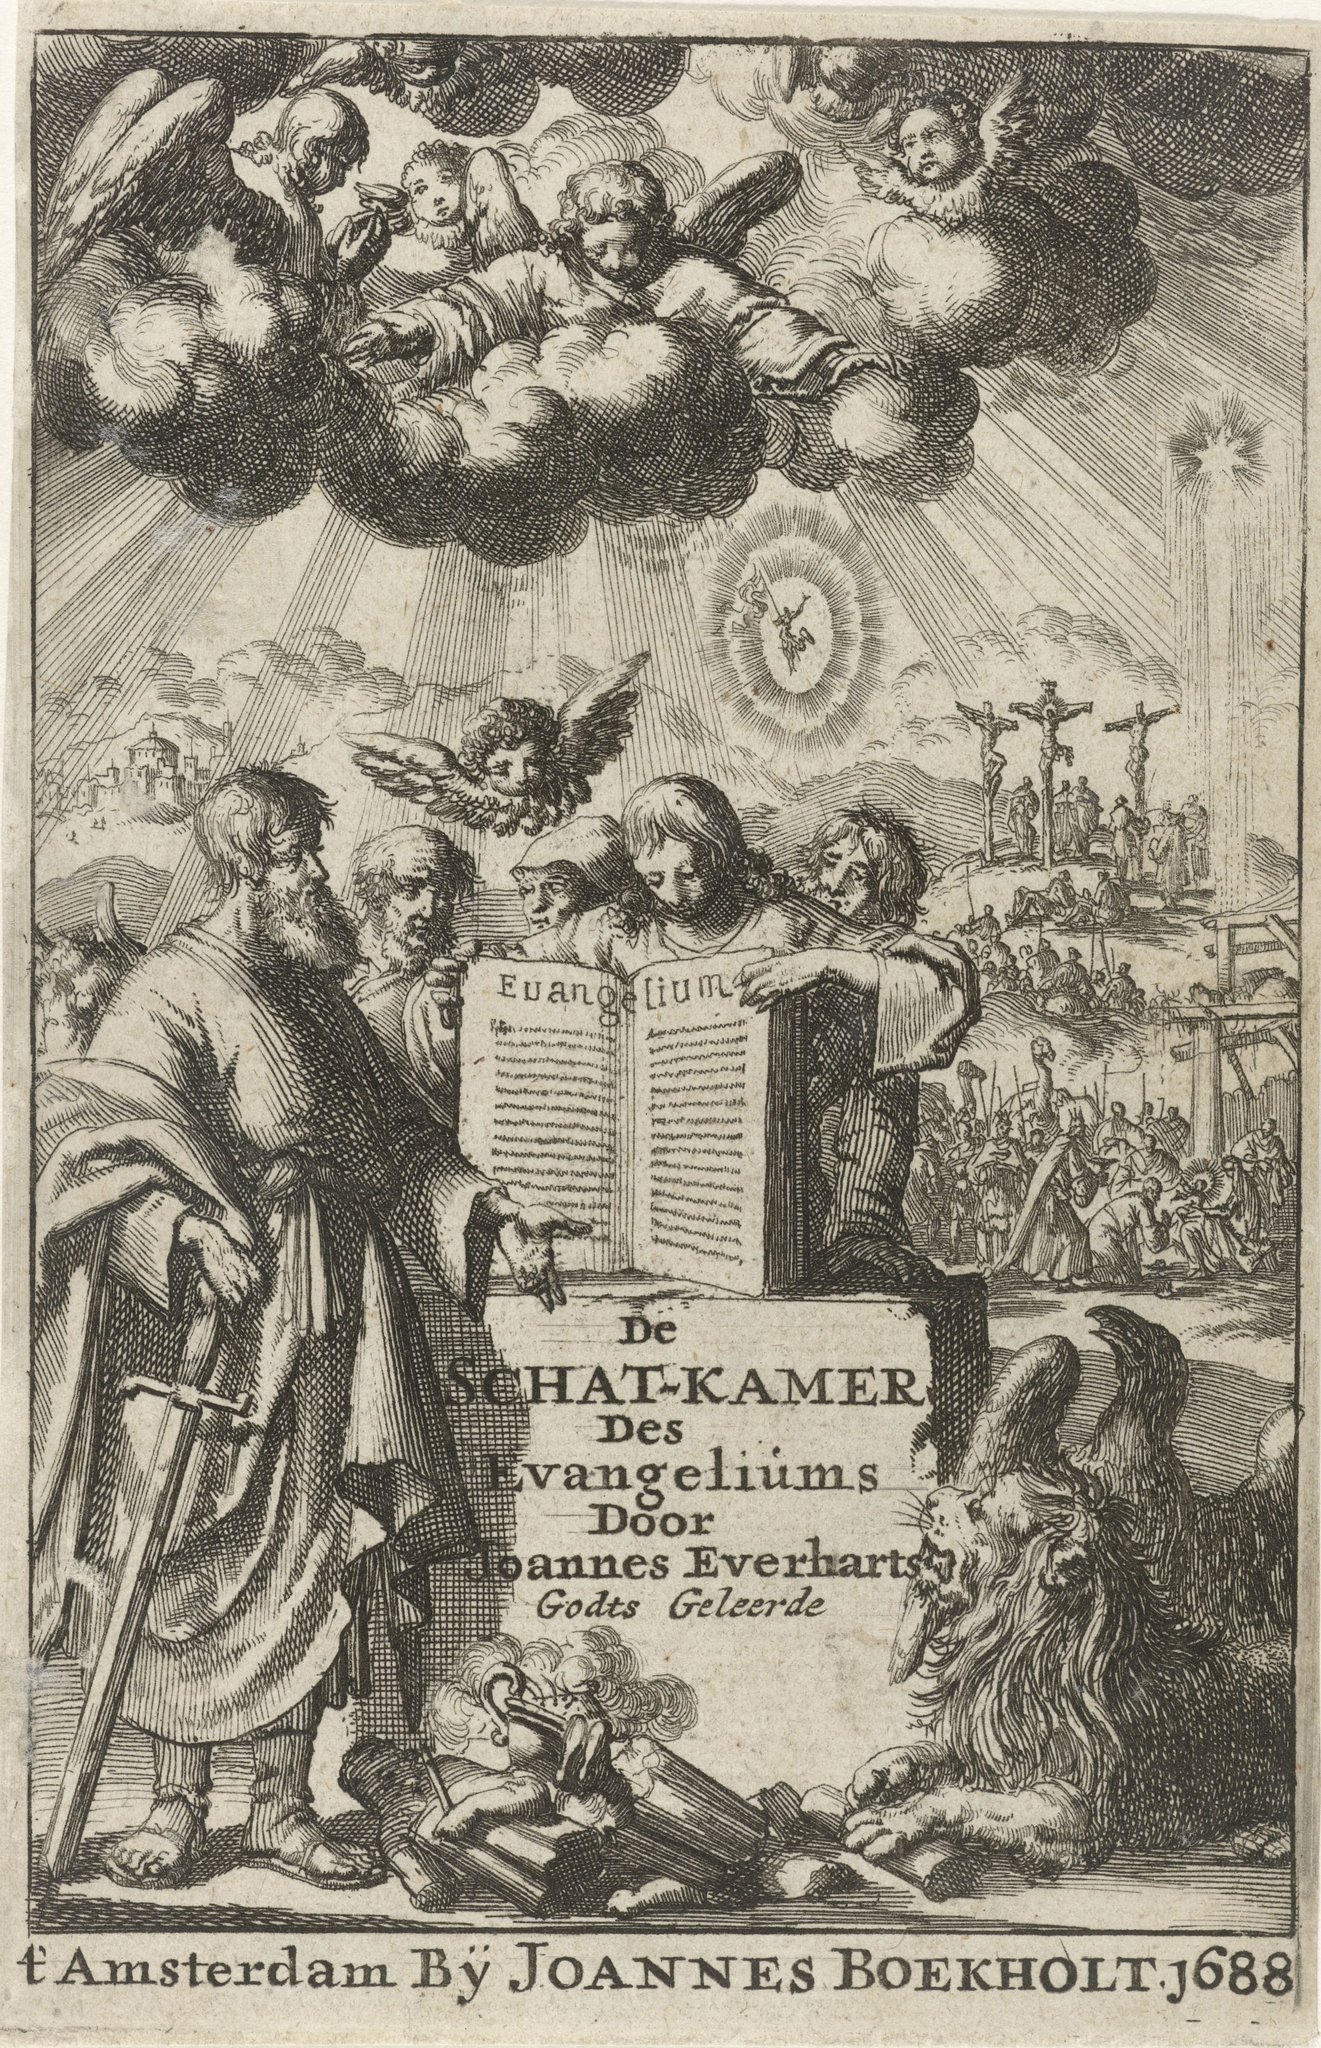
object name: print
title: Johannes toont Paulus het evangelie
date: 1688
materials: paper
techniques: etching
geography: amsterdam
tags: the four evangelists ~ other themes, adoration of the kings: the wise men present their gifts to the christ-child (gold, frankincense and myrrh), resurrection of christ, the crucifixion of christ: christ's death on the cross; golgotha (matthew 27:45-58; mark 15:33-45; luke 23:44-52; john 19:25-38), the apostle paul of tarsus; possible attributes: book, scroll, sword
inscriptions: collector's mark: Lugt 2228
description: Johannes toont Paulus het evangelie. Achter Johannes staan de drie andere evangelisten Matteüs, Marcus en Lucas. In de verte de aanbidding der wijzen, de kruisiging en de opstanding van Christus.